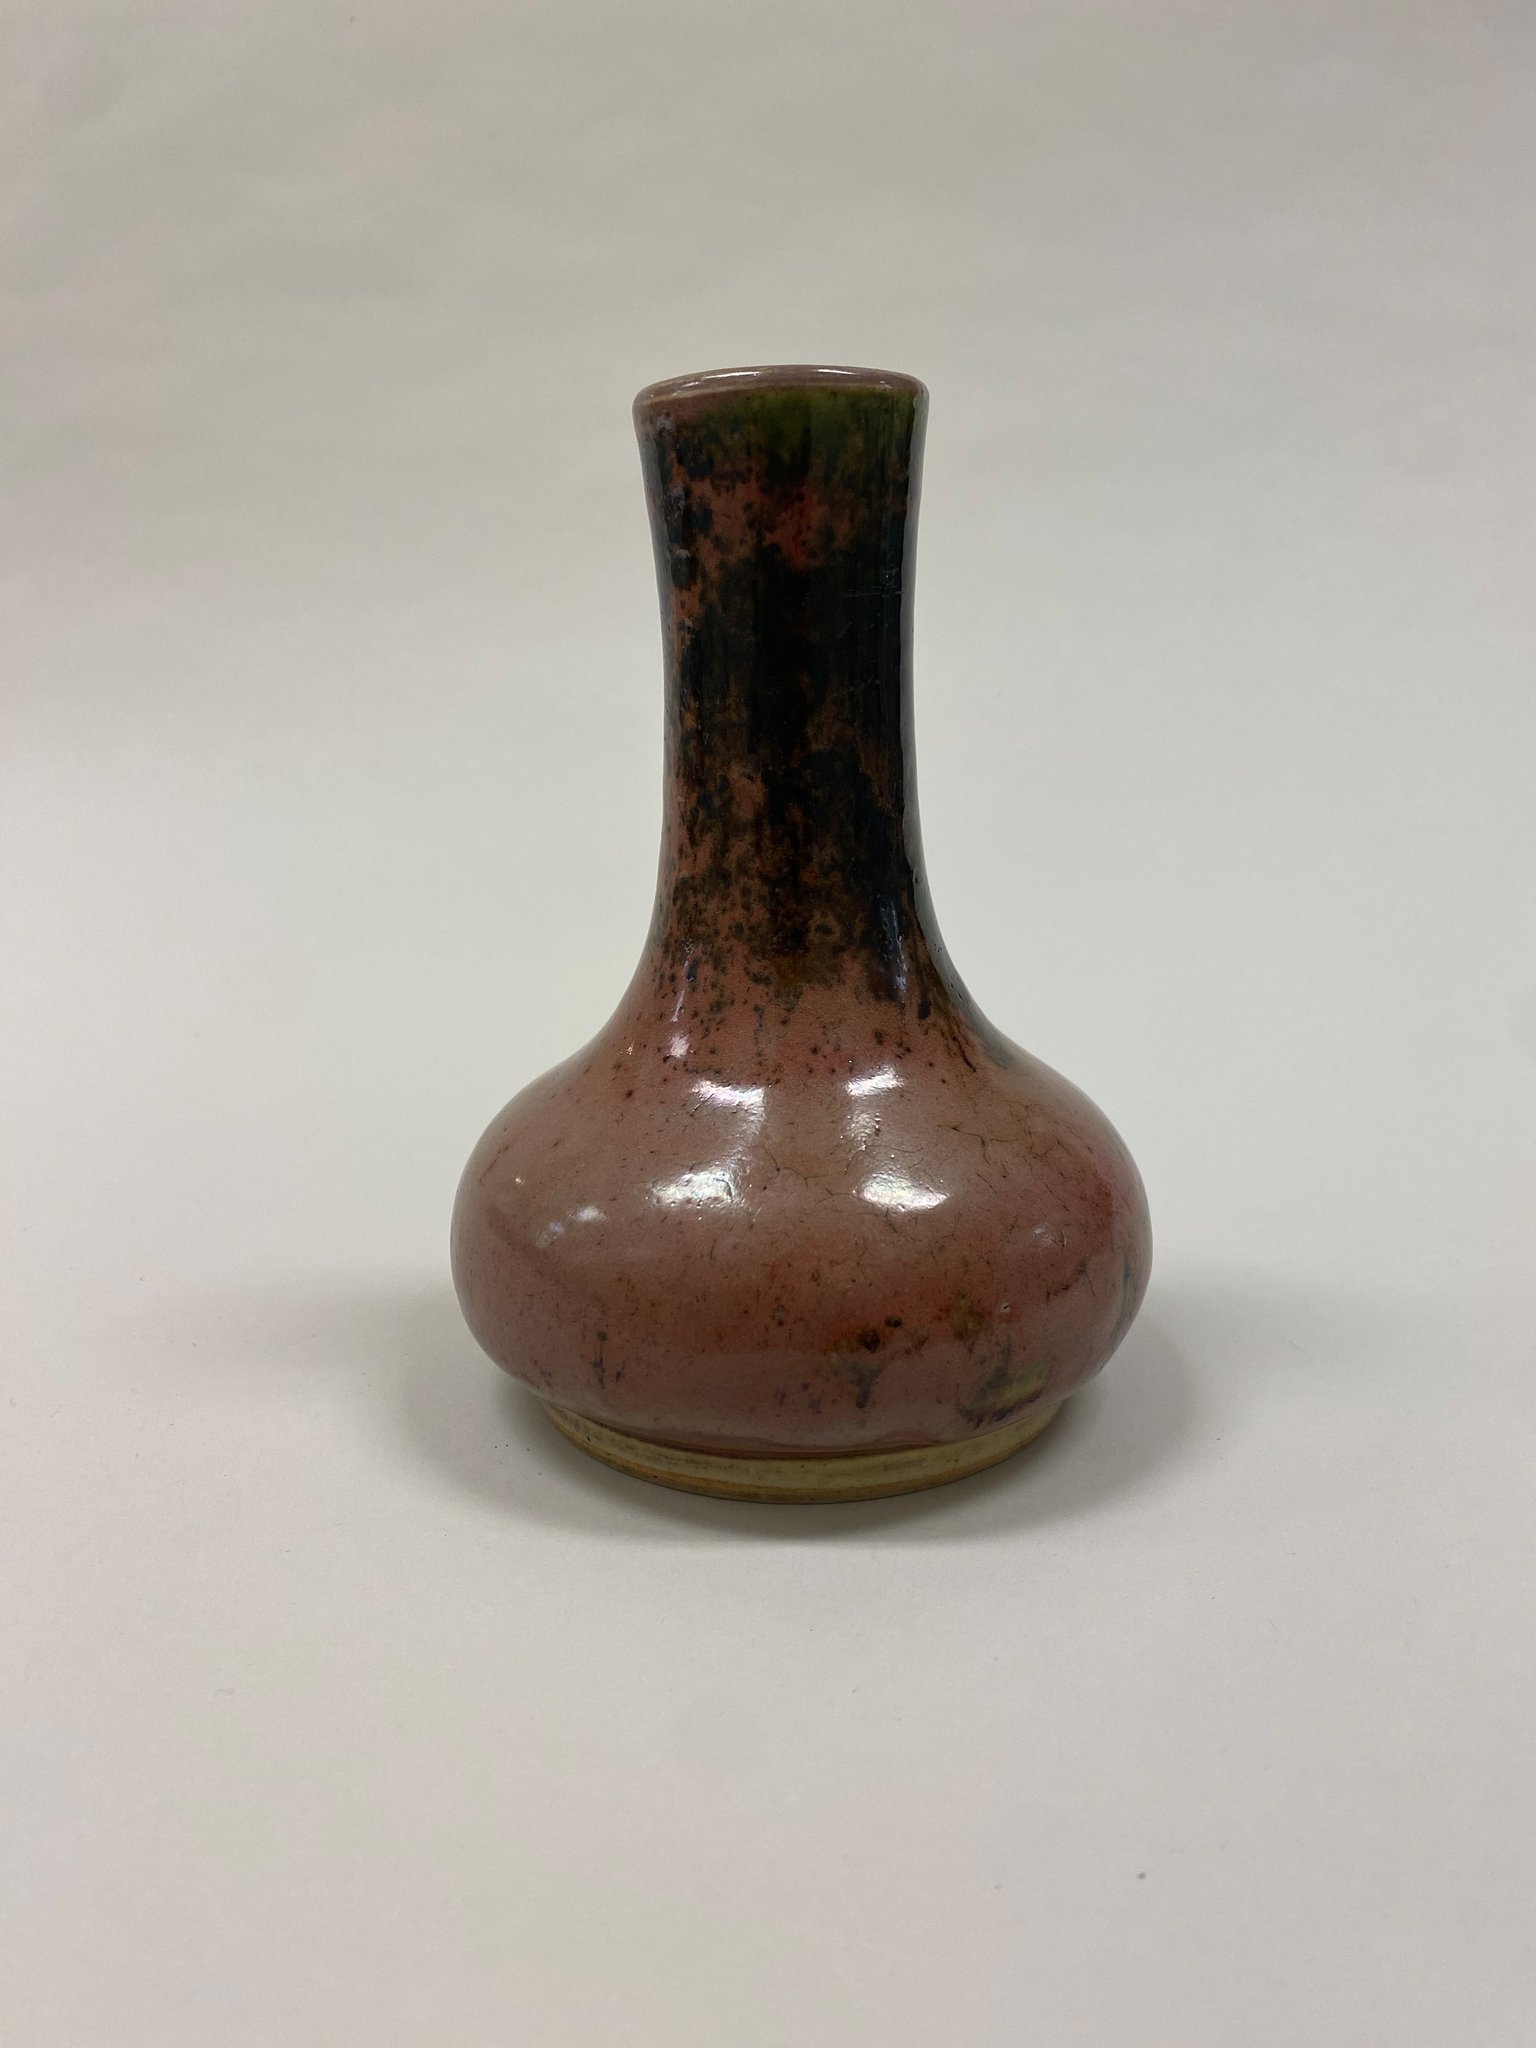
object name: vase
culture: chinese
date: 1801-1900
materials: glaze, porcelain